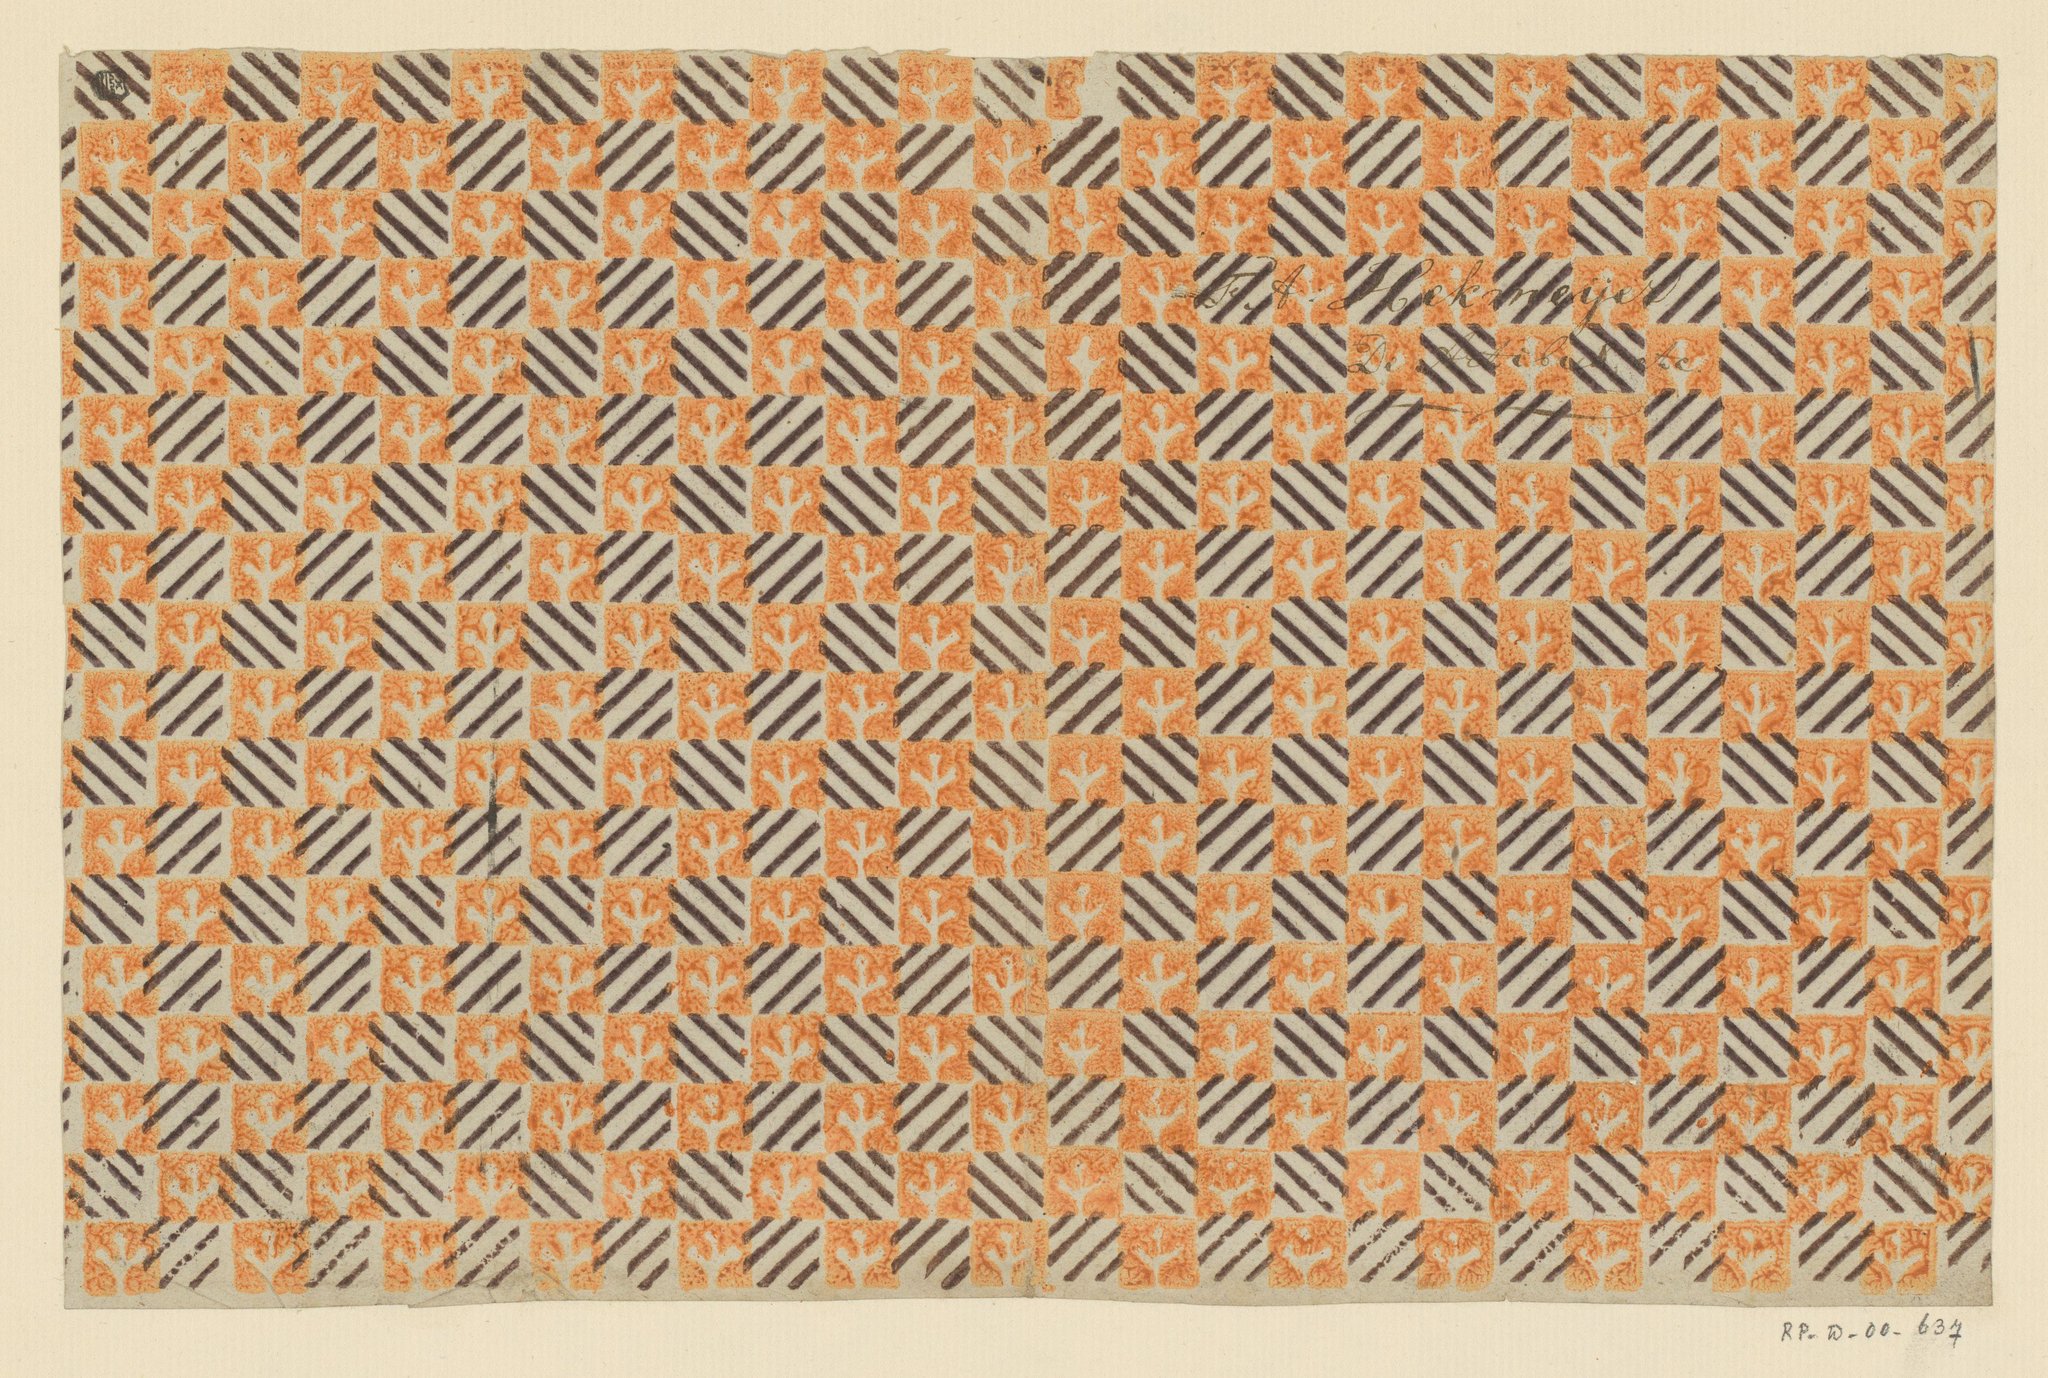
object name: printed paper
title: Blad met schaakbordpatroon van streepmotief en van uitgespaard takmotief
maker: Anonymous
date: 1750-1900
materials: paper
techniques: printing block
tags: ornament ~ geometric motifs, ornament derived from plant forms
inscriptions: collector's mark: Lugt 2760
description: Blad met schaakbordpatroon van een diagonaal streepmotief en van uitgespaard takmotief.